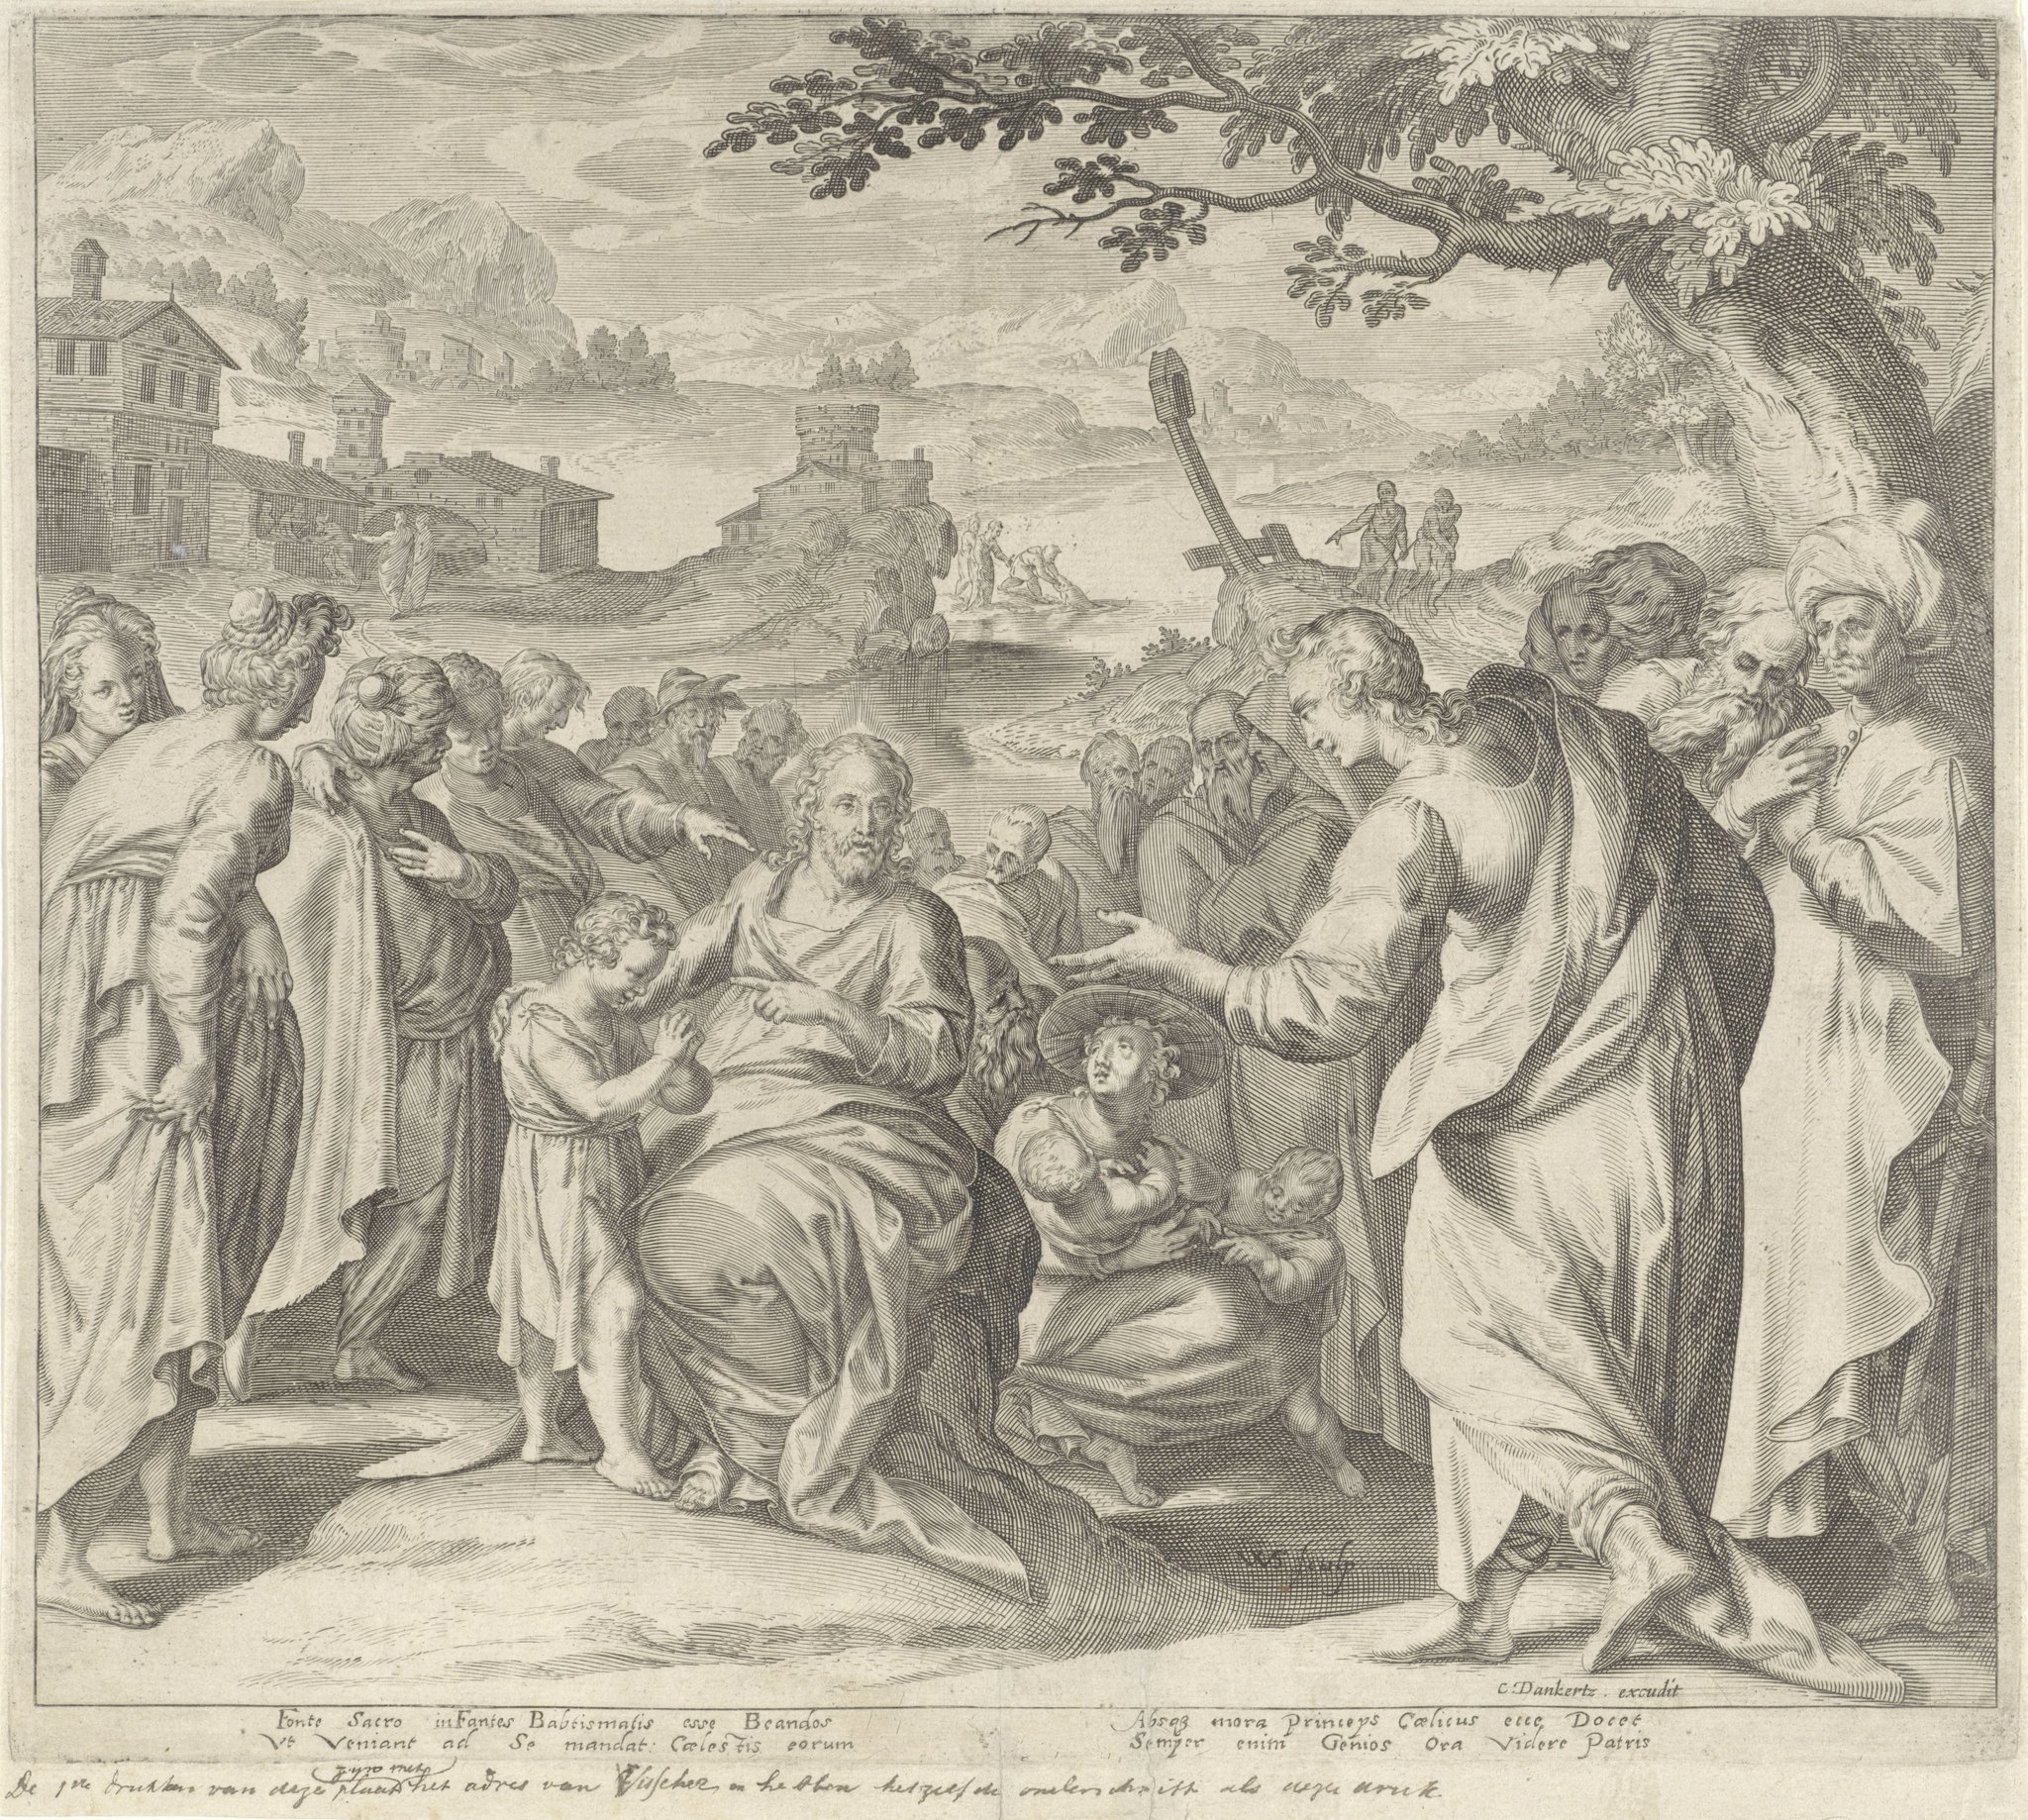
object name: print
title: Christus zegent de kinderen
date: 1630-1656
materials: paper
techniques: engraving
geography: leiden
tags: christ blessing children brought by their mothers, usually with some disciples disapprovingly looking on (matthew 19:13-15; mark 10:13-16; luke 18:15-17)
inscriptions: collector's mark: Lugt 2228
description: Christus zit te midden van een groep mensen, onder wie enkelen van zijn leerlingen en een paar moeders. Naast hem zit een moeder met twee kinderen. Hij heeft zijn arm om een jongen met gevouwen handen geslagen en spreekt tot de leerling die voor hem staat. In de verte staan enkele huizen. Onder de voorstelling bevindt zich een vierregelige, Latijnse tekst met een beschrijving van wat Christus in de scène zegt.